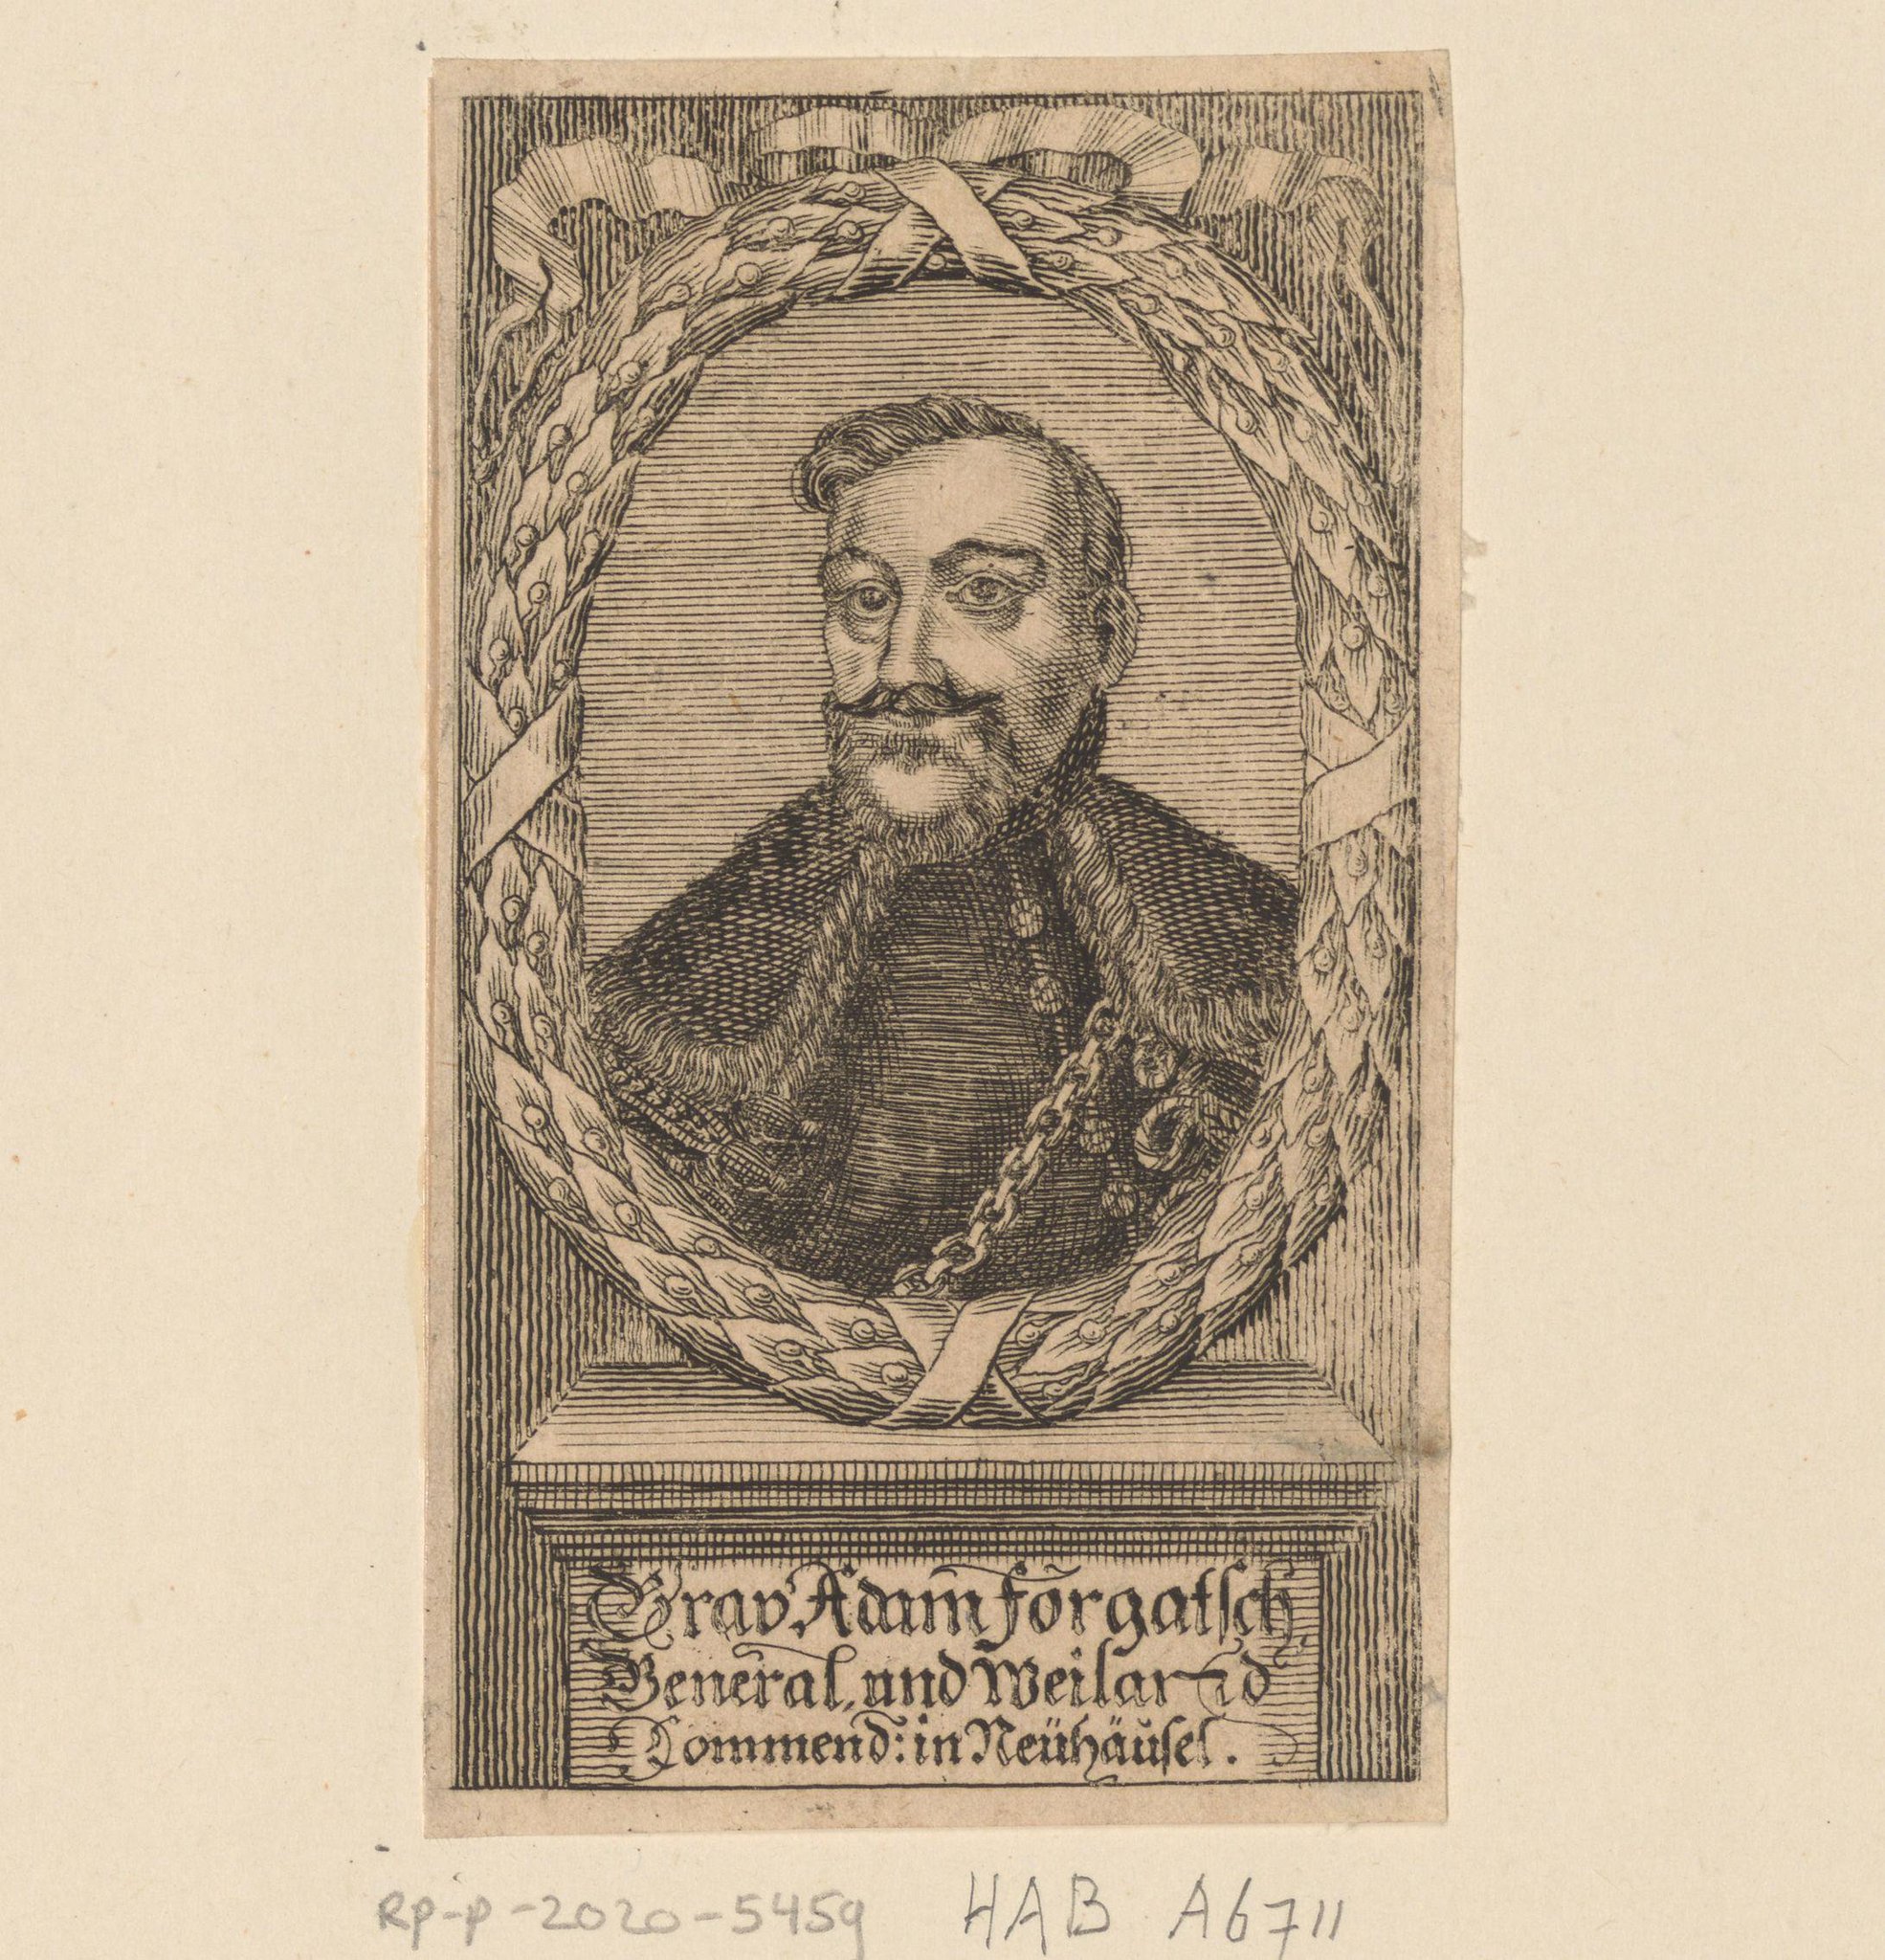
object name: print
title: Portret van Ádám Forgách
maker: Anonymous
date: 1650-1700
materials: paper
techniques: engraving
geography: germany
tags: historical persons